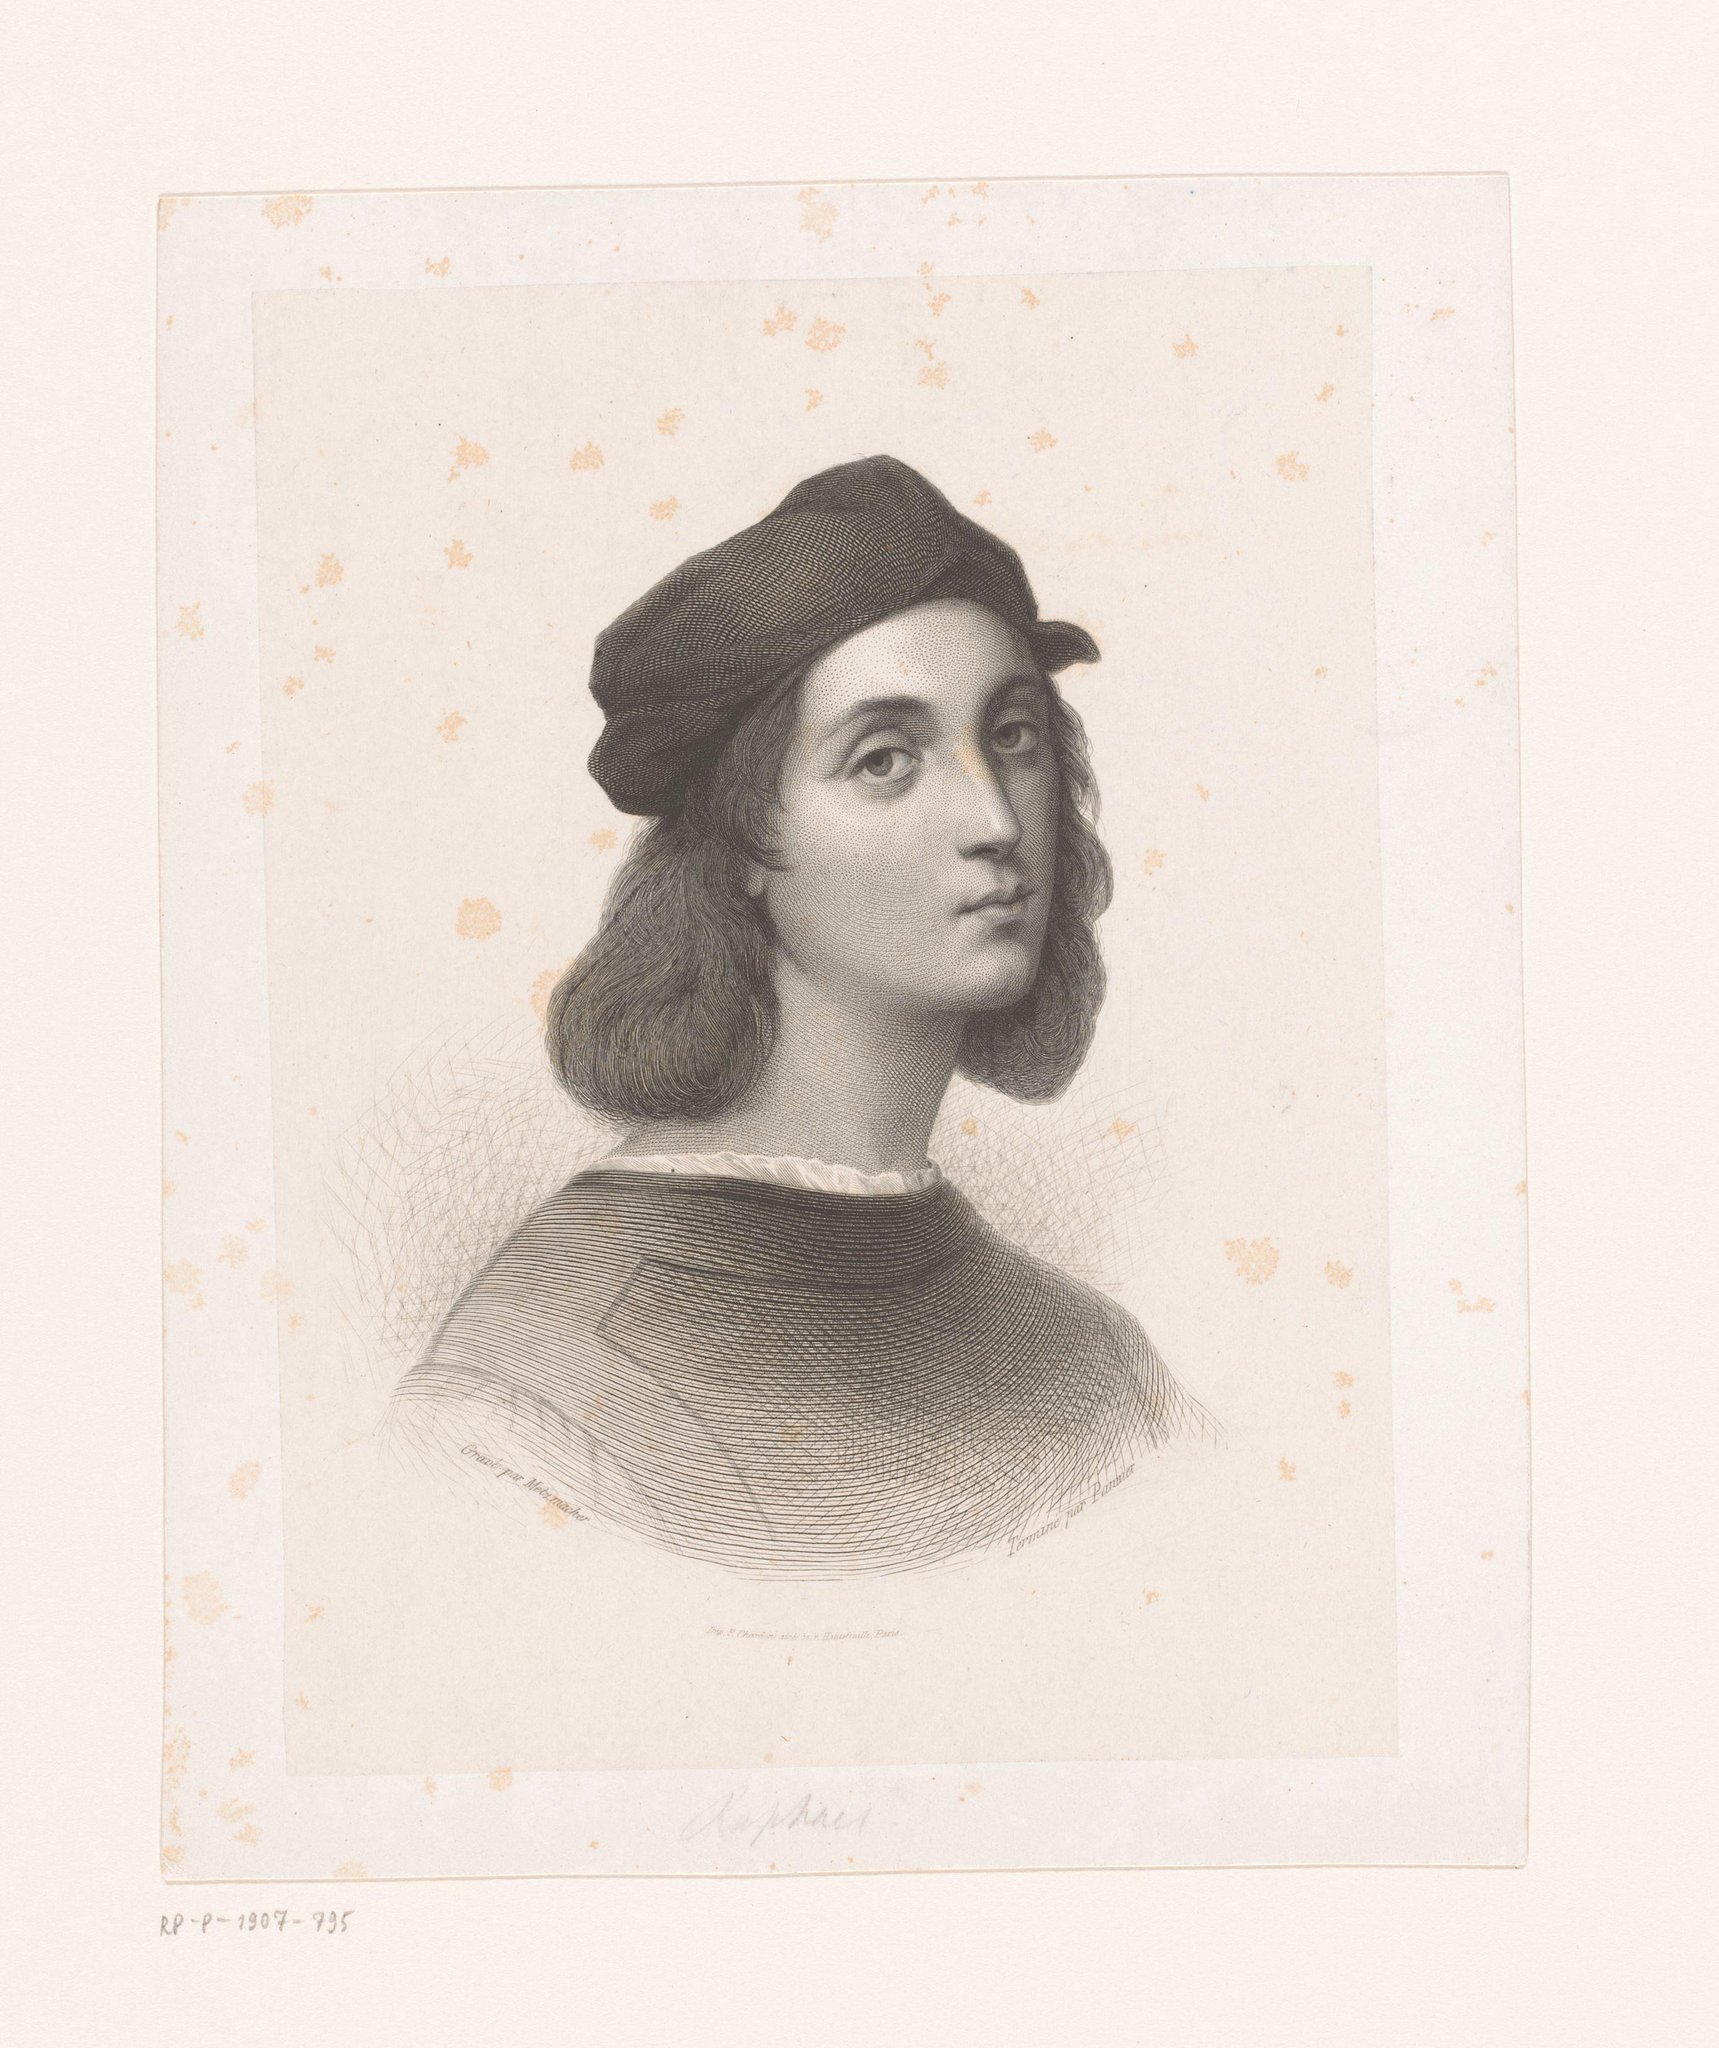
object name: print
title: Portret van Rafaël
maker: pierre guillaume metzmacher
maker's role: print maker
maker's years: 1815-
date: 1825-1915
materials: paper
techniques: engraving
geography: france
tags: painter, rafaël, historical persons, portrait, self-portrait of painter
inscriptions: collector's mark: Lugt 2228